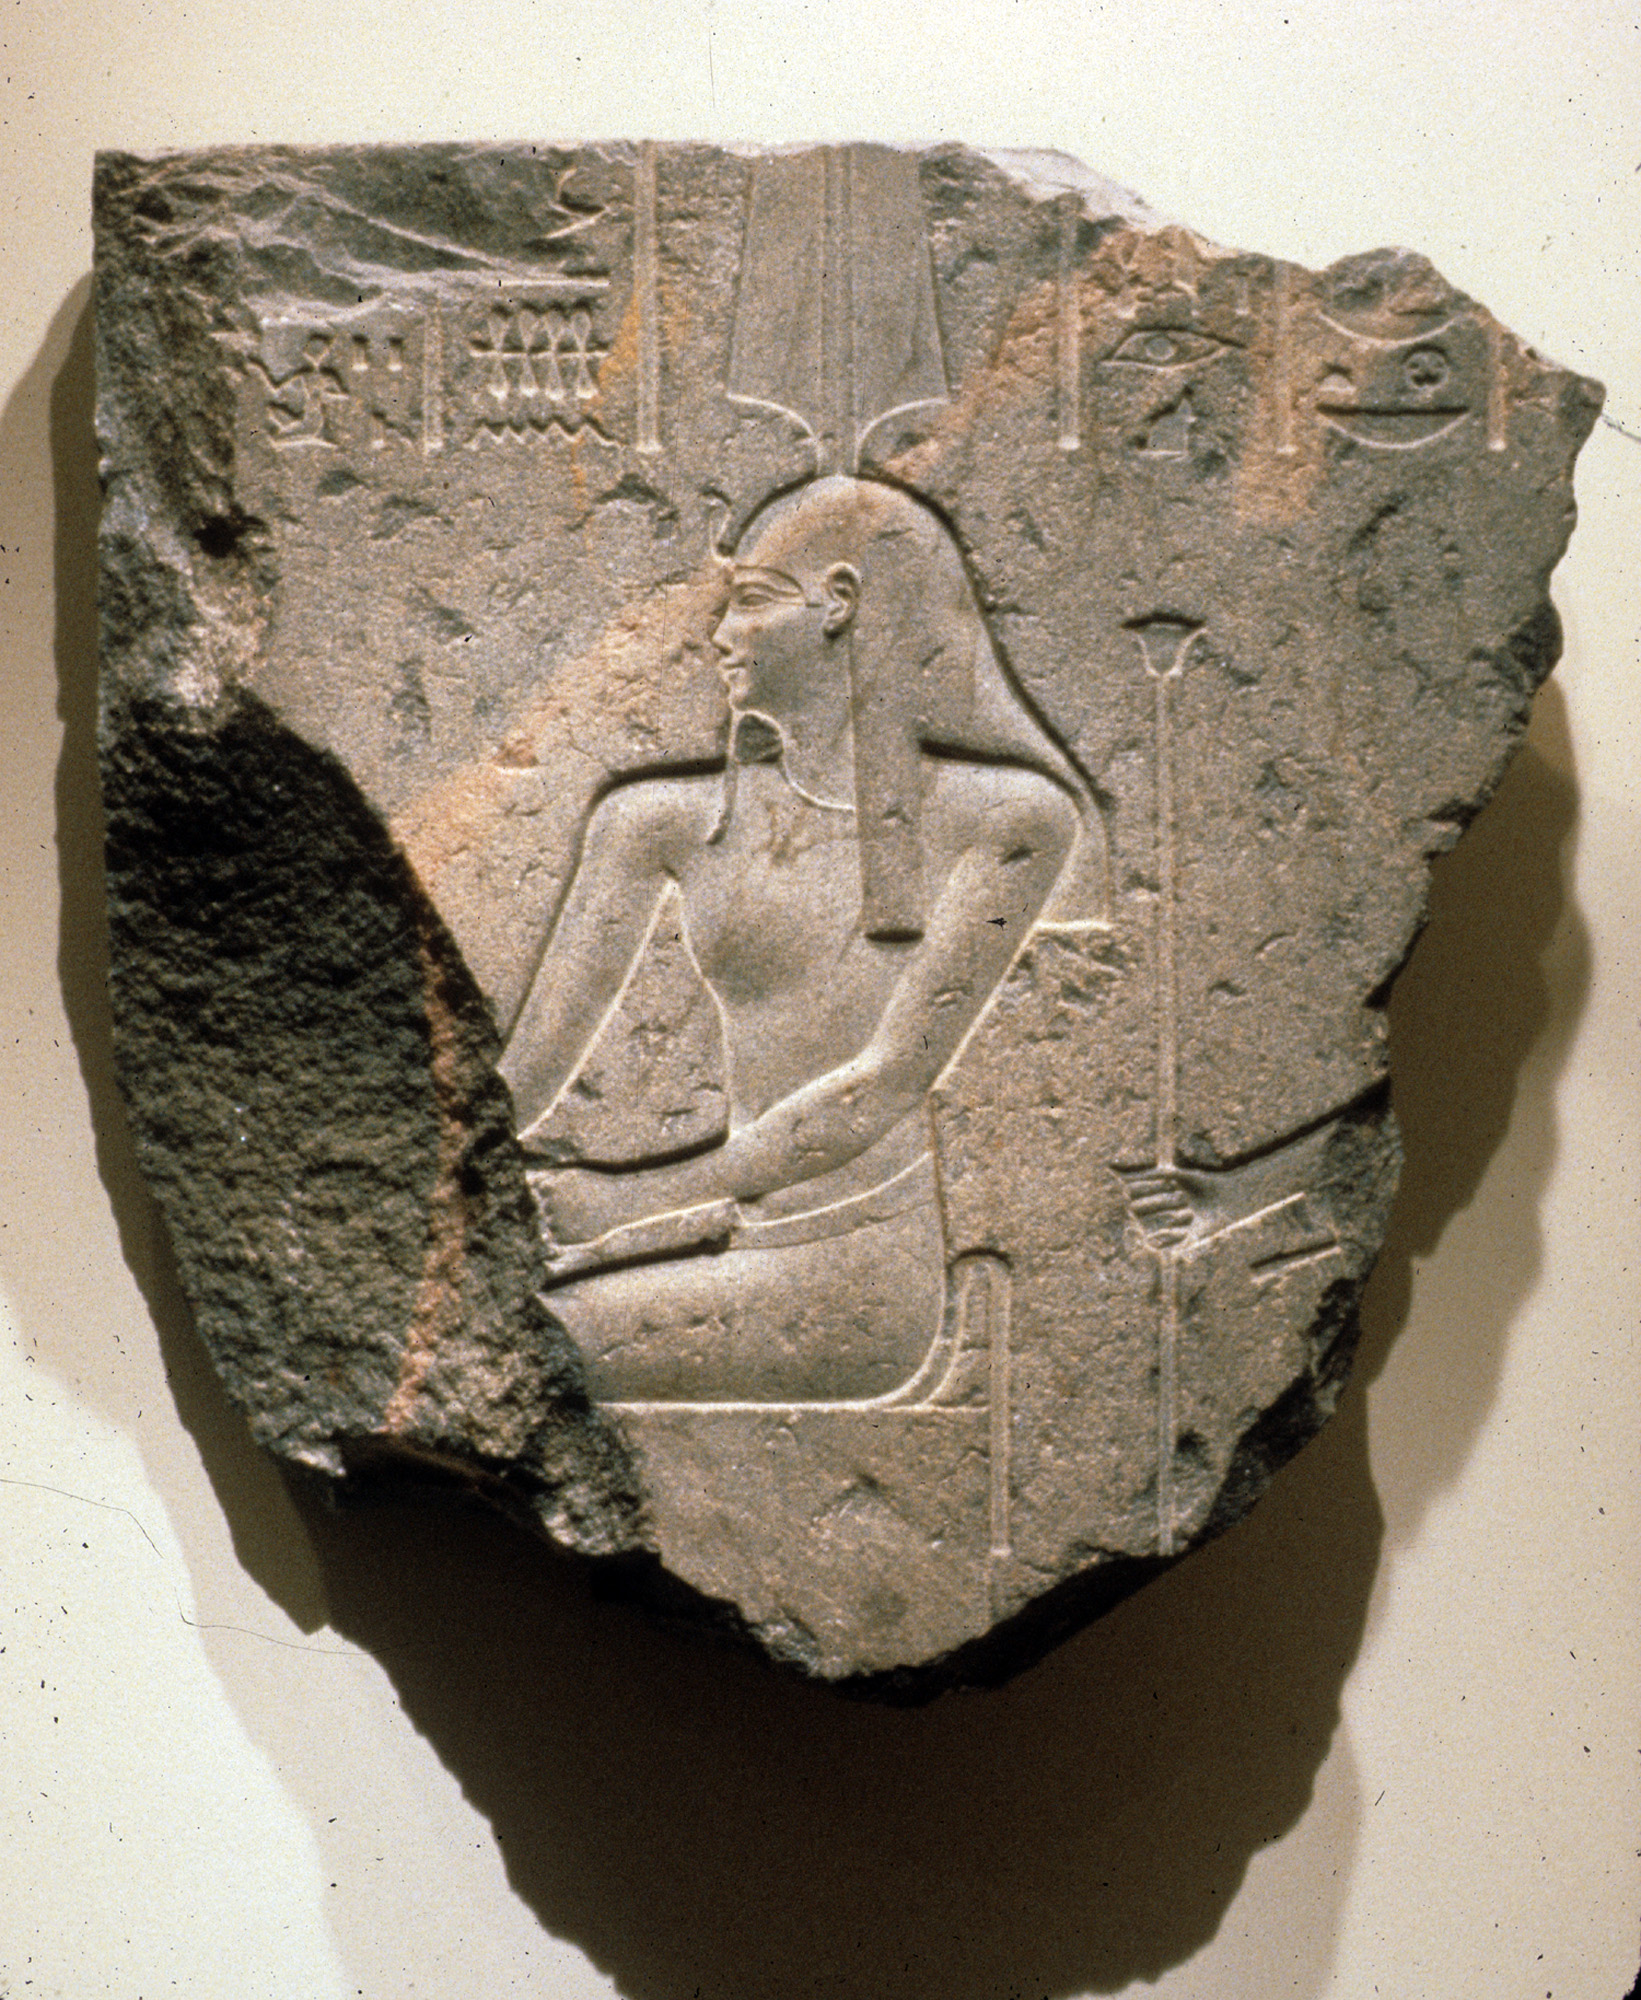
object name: relief, seated osiris anedjty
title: Seated Osiris-Anedjty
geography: egypt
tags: men